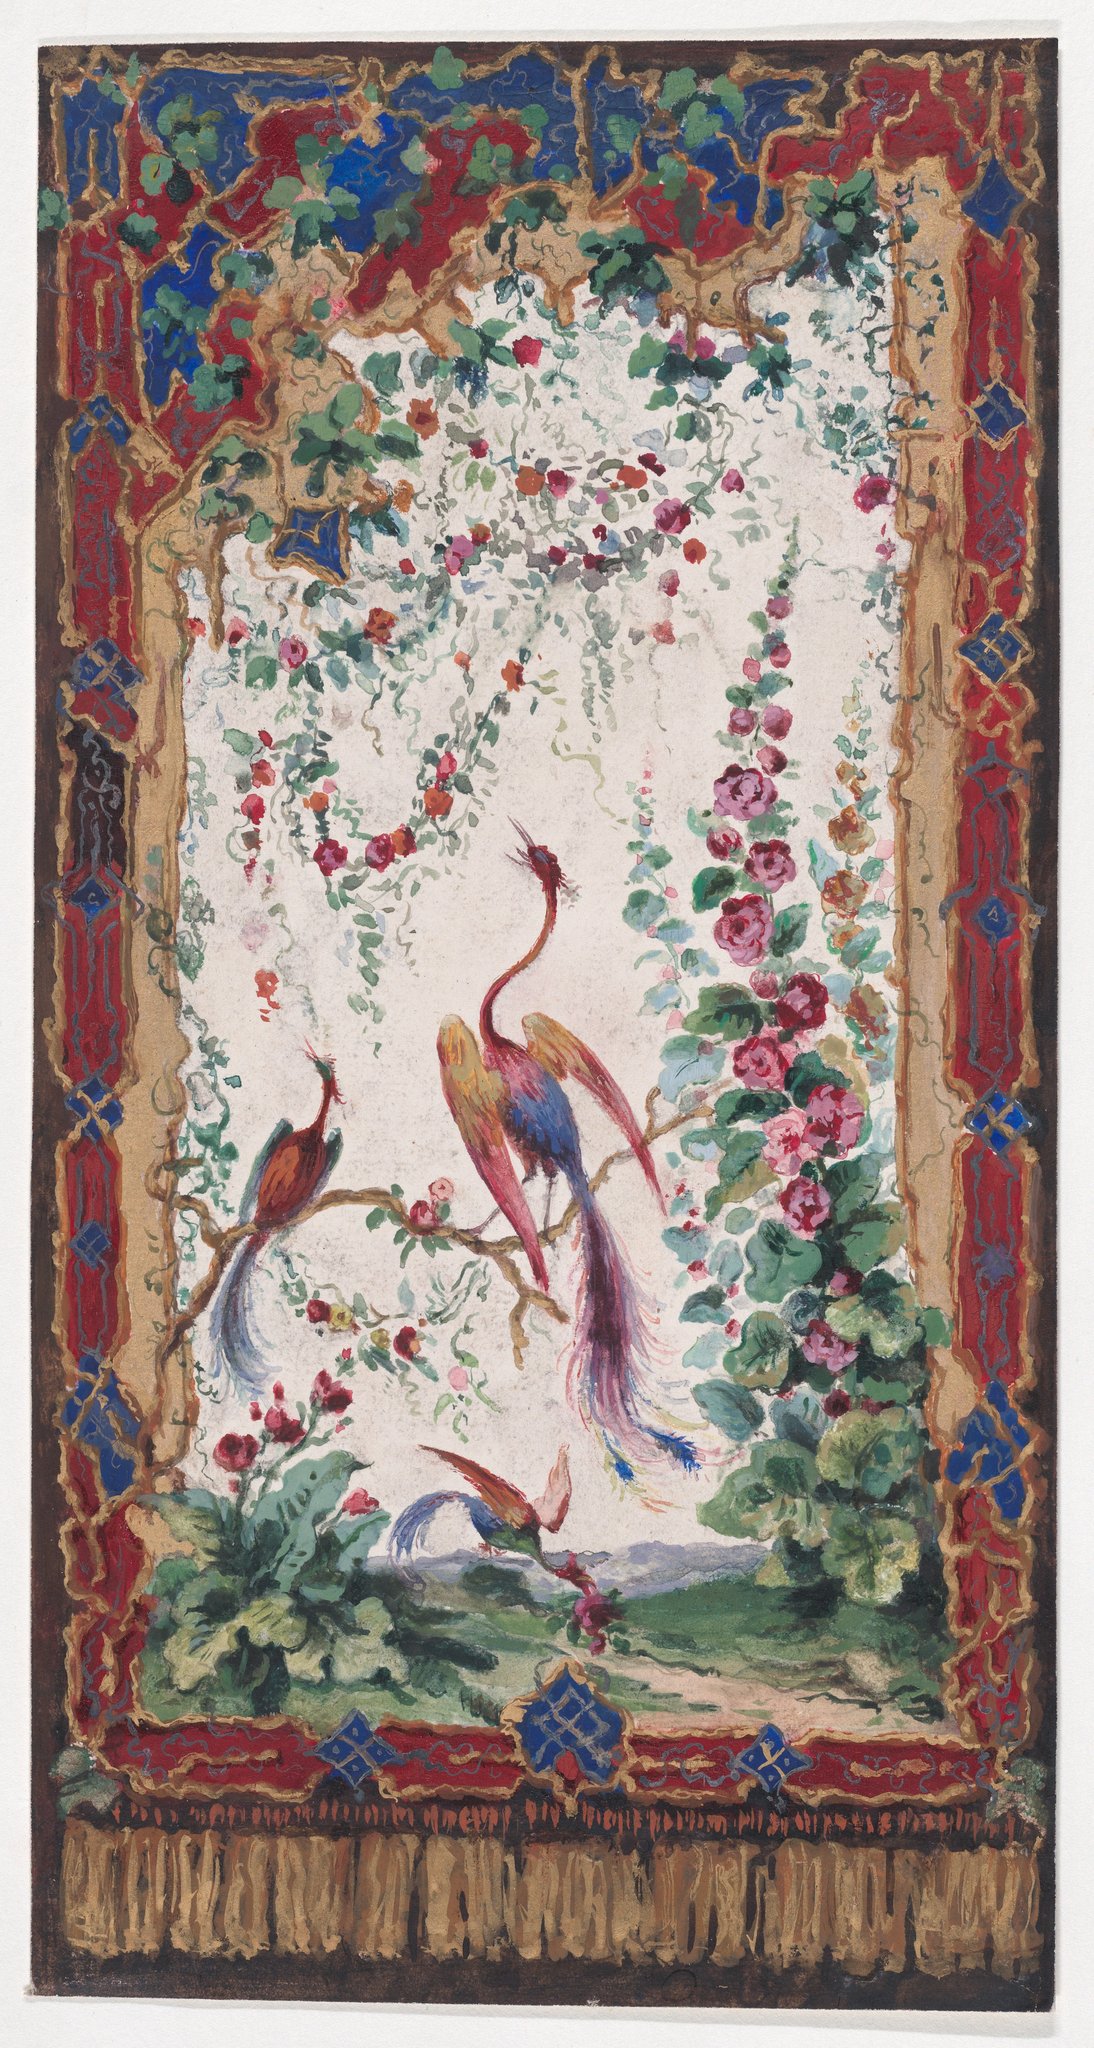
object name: drawing ornament architecture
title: Design for Wallpaper or Panel (?) with an Orientalist Motif with Three Phoenix-Like Exotic Birds with Colorful Feathers and a Flowering Tree within an Ornamental Frame with Tassels Resembling a Tapestry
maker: anonymous, french, 19th century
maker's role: designer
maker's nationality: french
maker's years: 1800-1900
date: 1870-1900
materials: watercolor